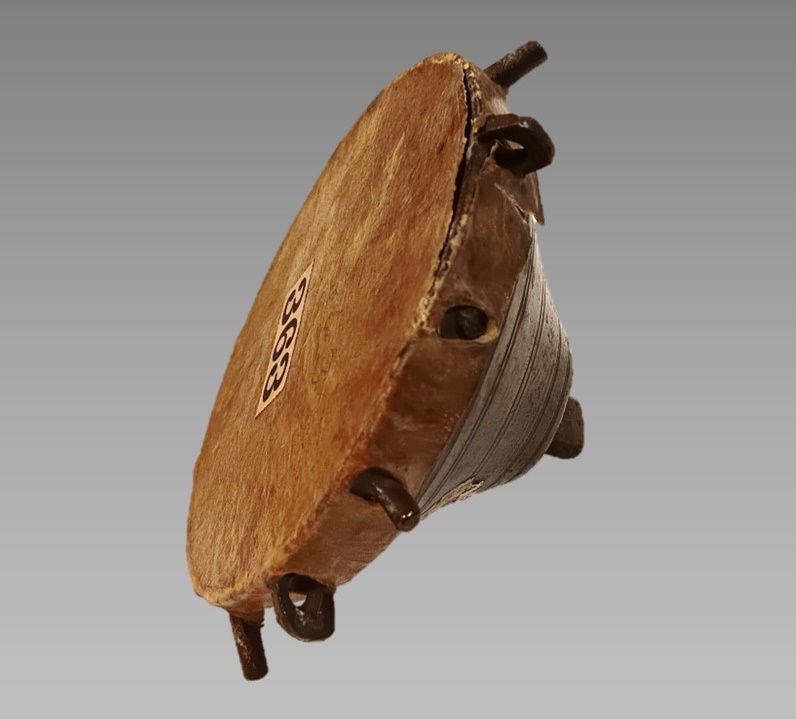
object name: tabl i baz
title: Tabl-i baz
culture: turkish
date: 1867-1900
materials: brass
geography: turkey